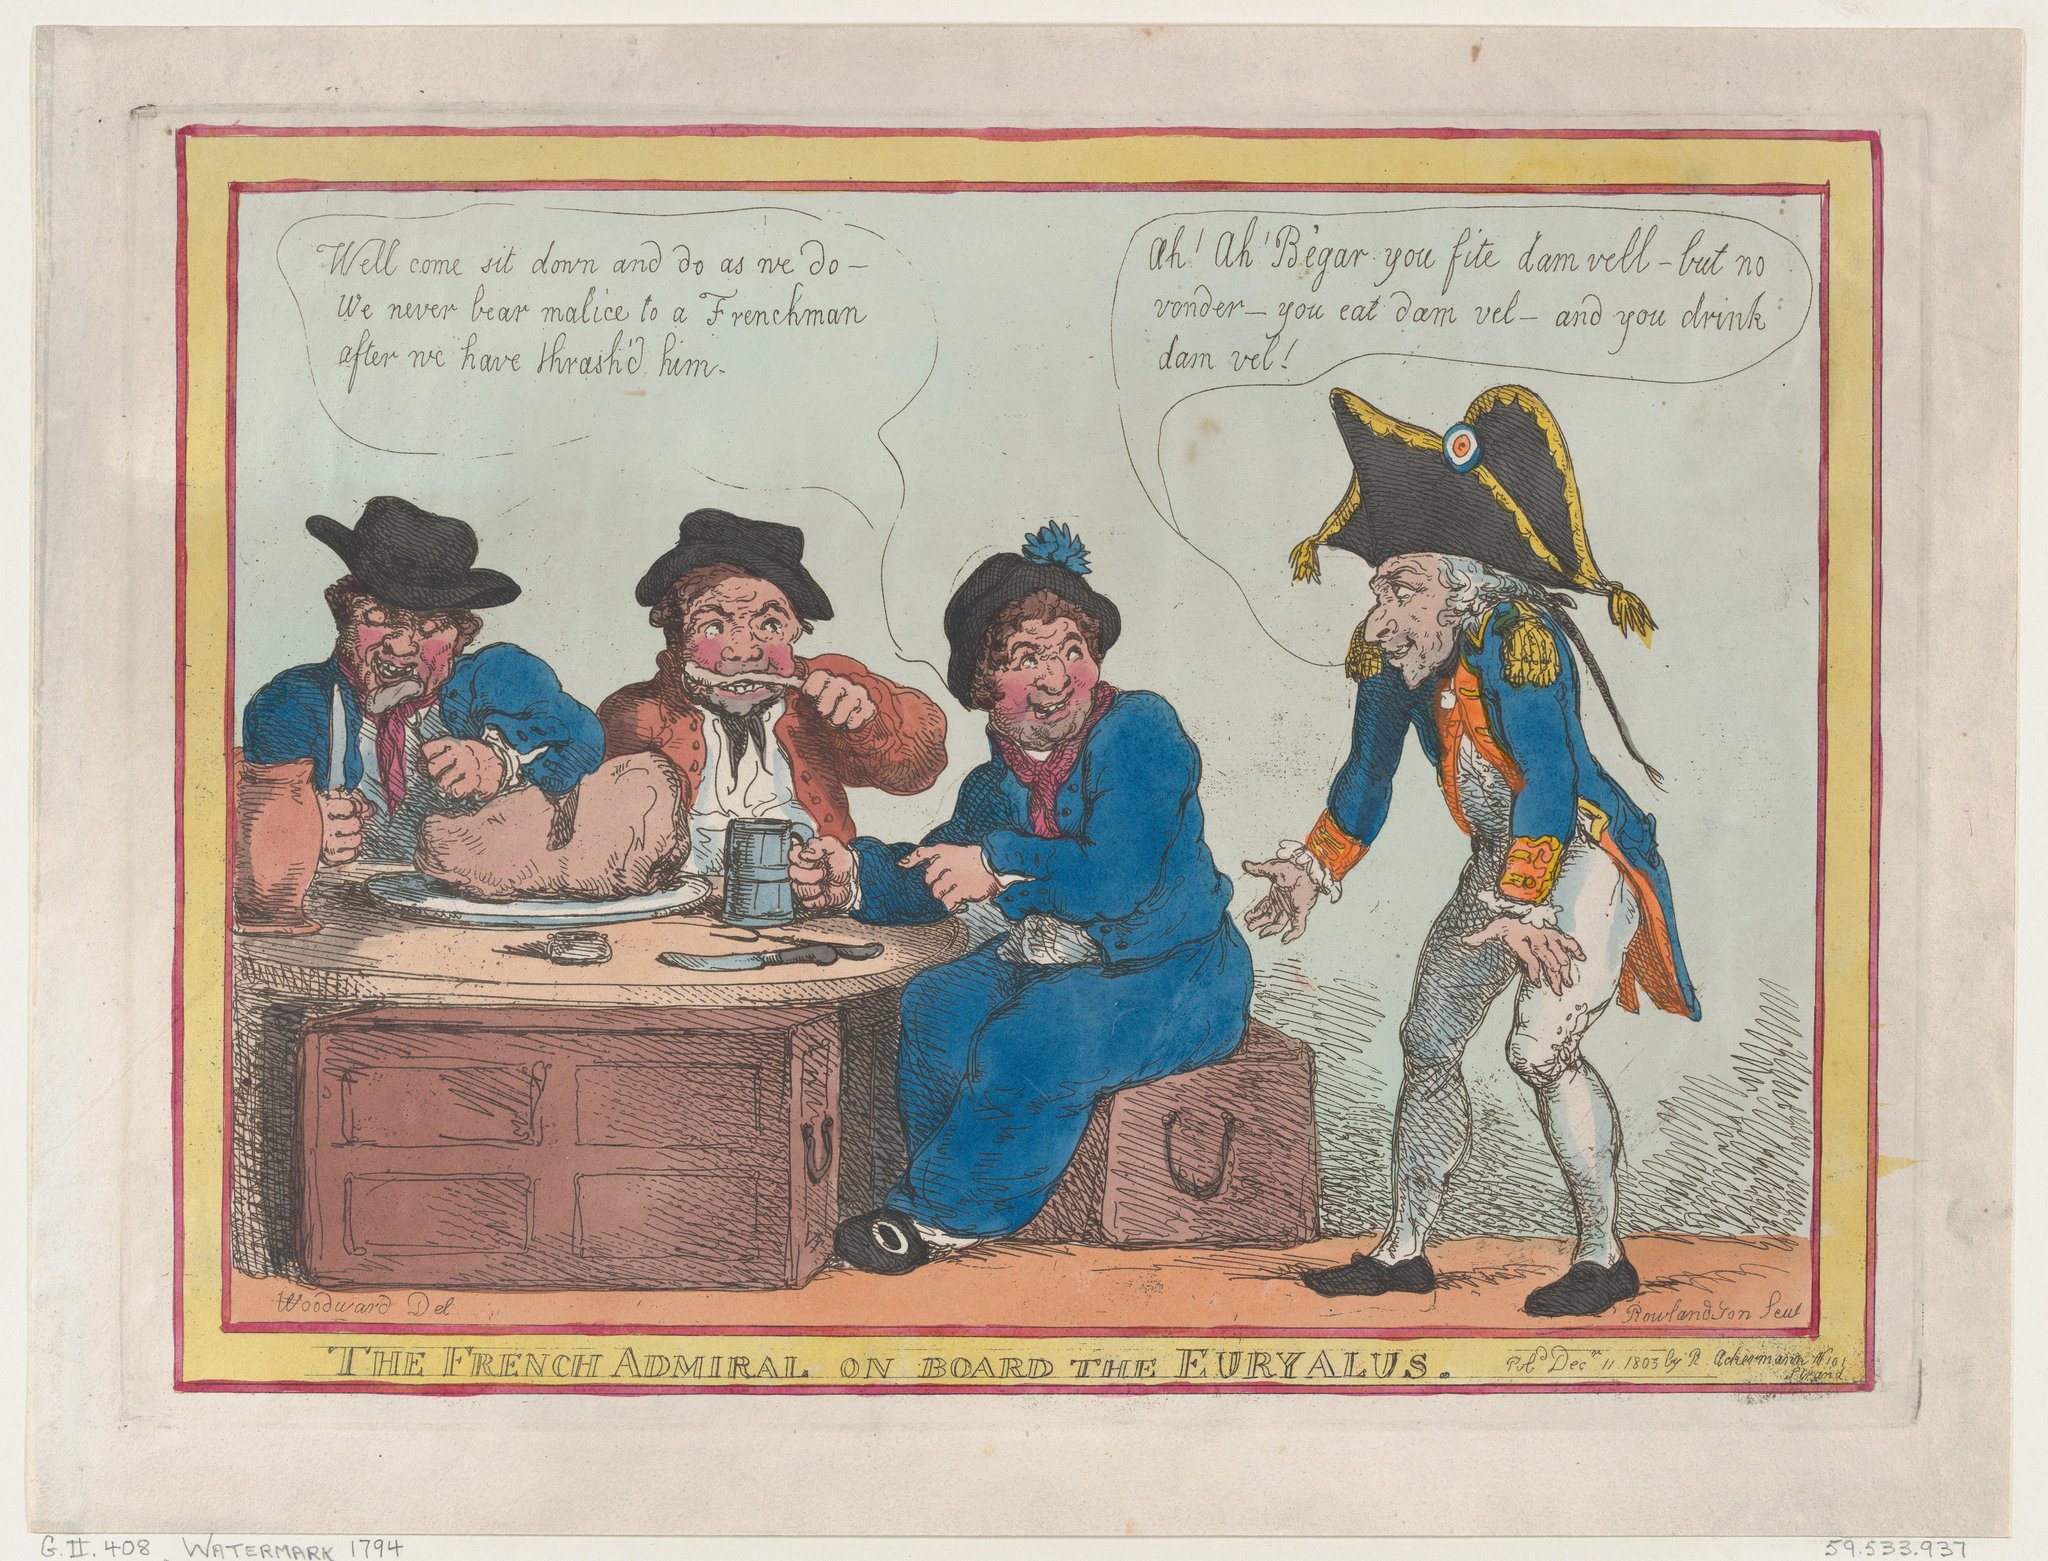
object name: print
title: The French Admiral on Board the Euryalus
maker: thomas rowlandson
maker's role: artist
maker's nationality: british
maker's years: 1757-1827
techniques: etching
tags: food,satire,men,dining,admirals